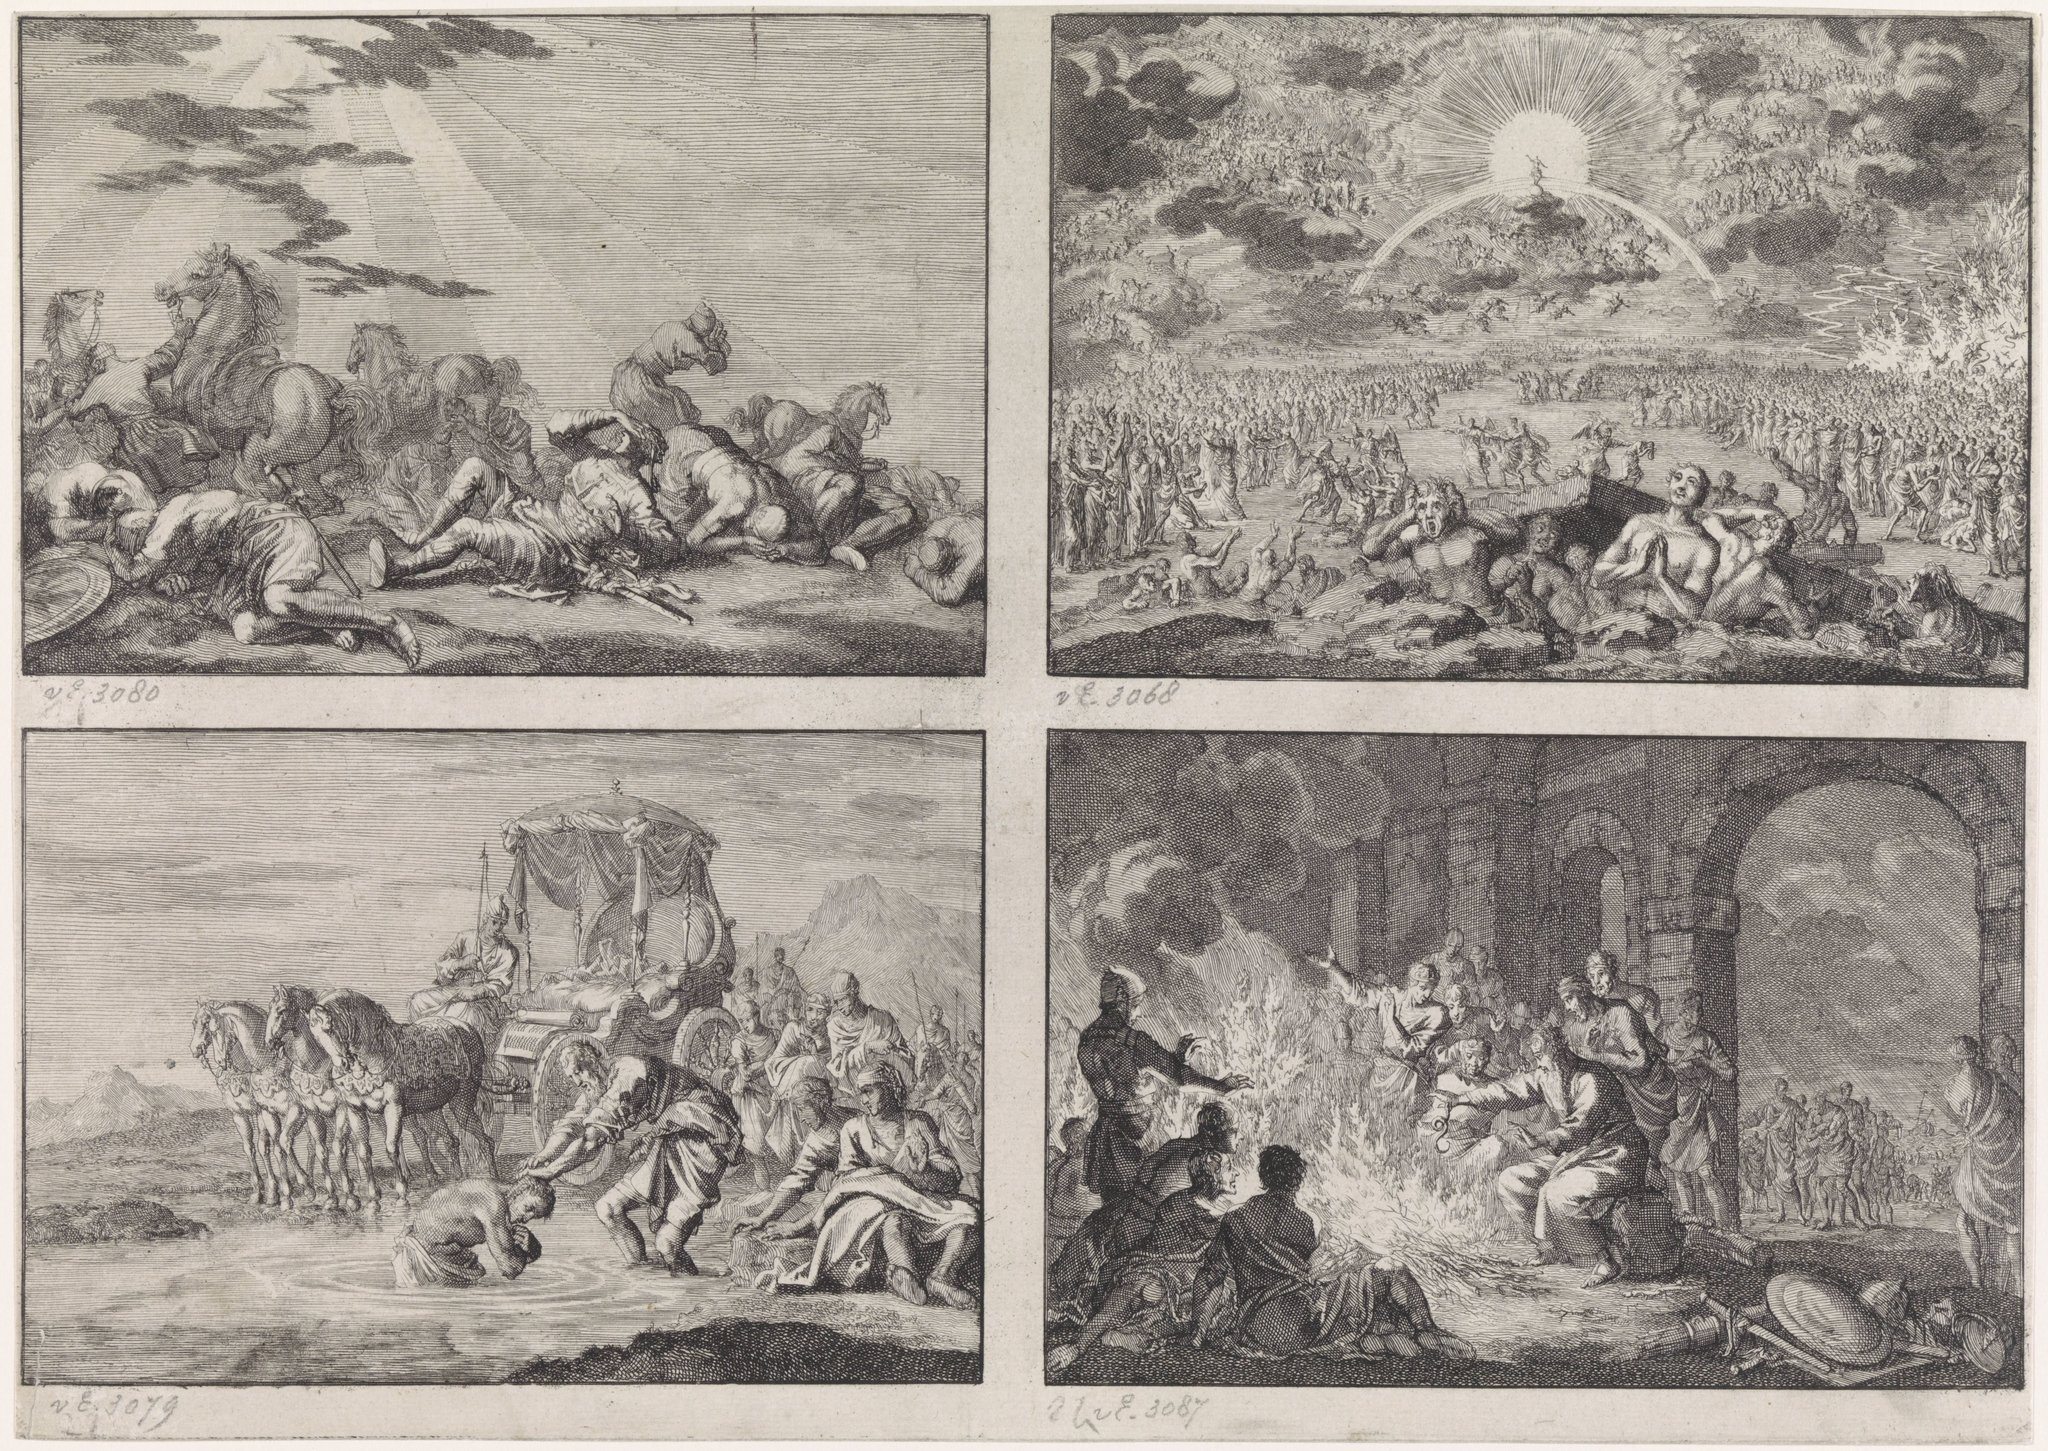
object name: print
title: Vier voorstellingen uit het Nieuwe Testament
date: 1703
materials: paper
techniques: etching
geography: amsterdam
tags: on the way to damascus christ appears to saul, who falls from his horse and is blinded by the light, paul bitten by a viper (when throwing wood on the fire), philip baptizes the eunuch, resurrection of the dead ~ last judgement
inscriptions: collector's mark: Lugt 2228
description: Proefdruk van boekillustraties voor David Martin. Historie des Ouden en Nieuwen Testaments. Amsterdam, Pieter Mortier, 1703. Deel II. De boekillustraties voor de Mortierbijbel hebben verschillende staten en kopieën, waarbij de chronologische volgorde moeilijk te achterhalen valt. Als boekillustraties werden ze bovendien herhaaldelijk opnieuw gebruikt voor andere boekwerken.